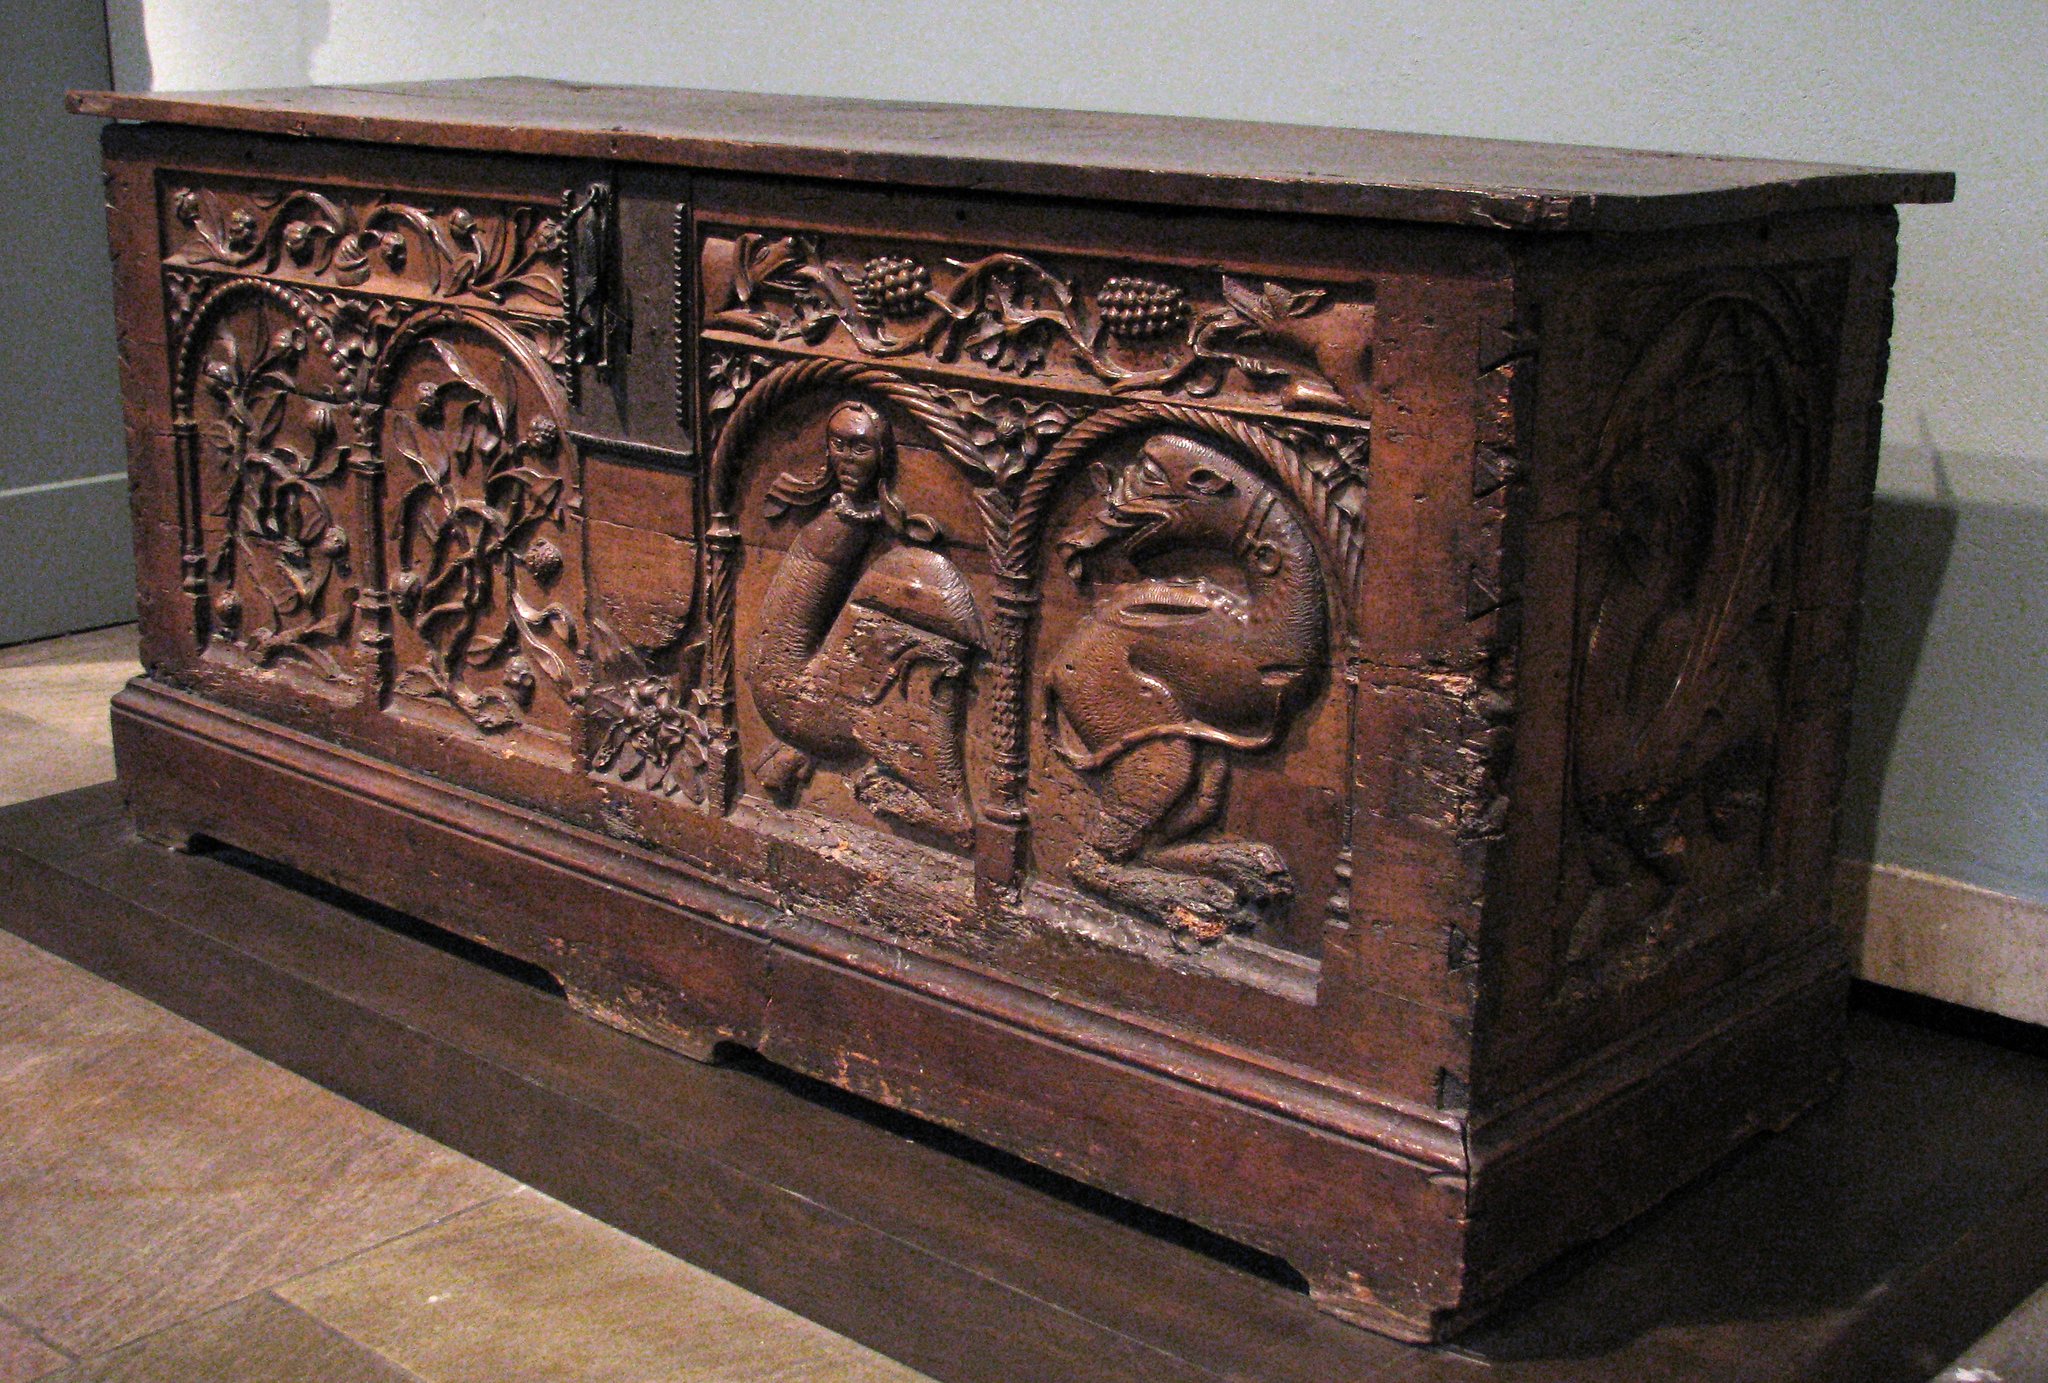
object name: chest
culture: dutch or french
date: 1467-1500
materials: iron, wood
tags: mythical creatures